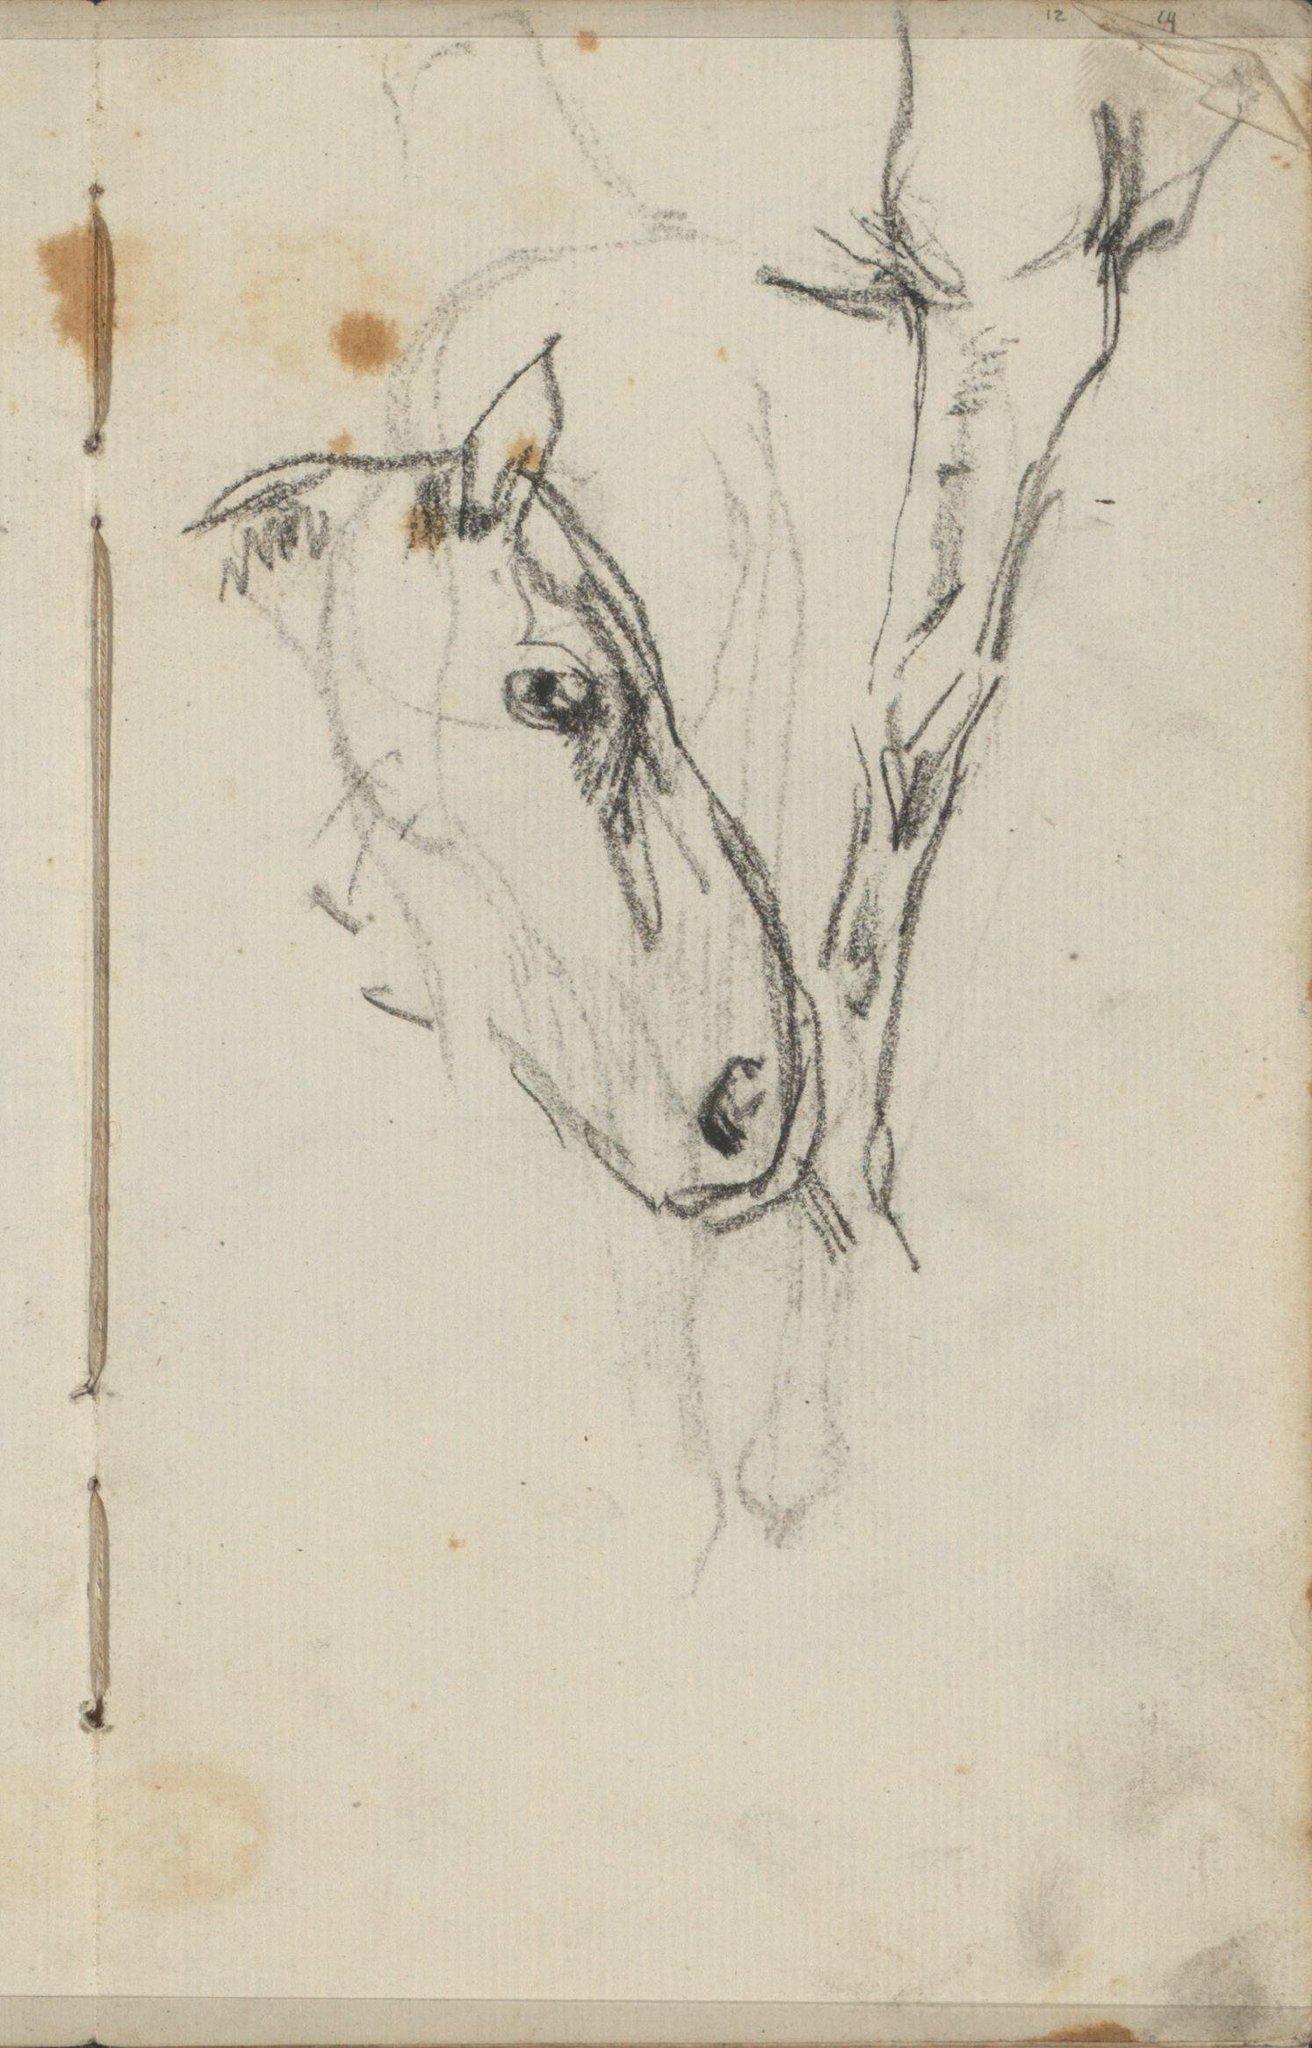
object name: sketchbook leaf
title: Paardenbeen en een paardenhoofd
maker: george hendrik breitner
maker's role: draughtsman, painter, print maker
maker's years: 1857-1923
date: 1883-1885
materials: chalk, paper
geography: the hague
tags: horse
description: Pagina 12 uit een schetsboek met 17 bladen.